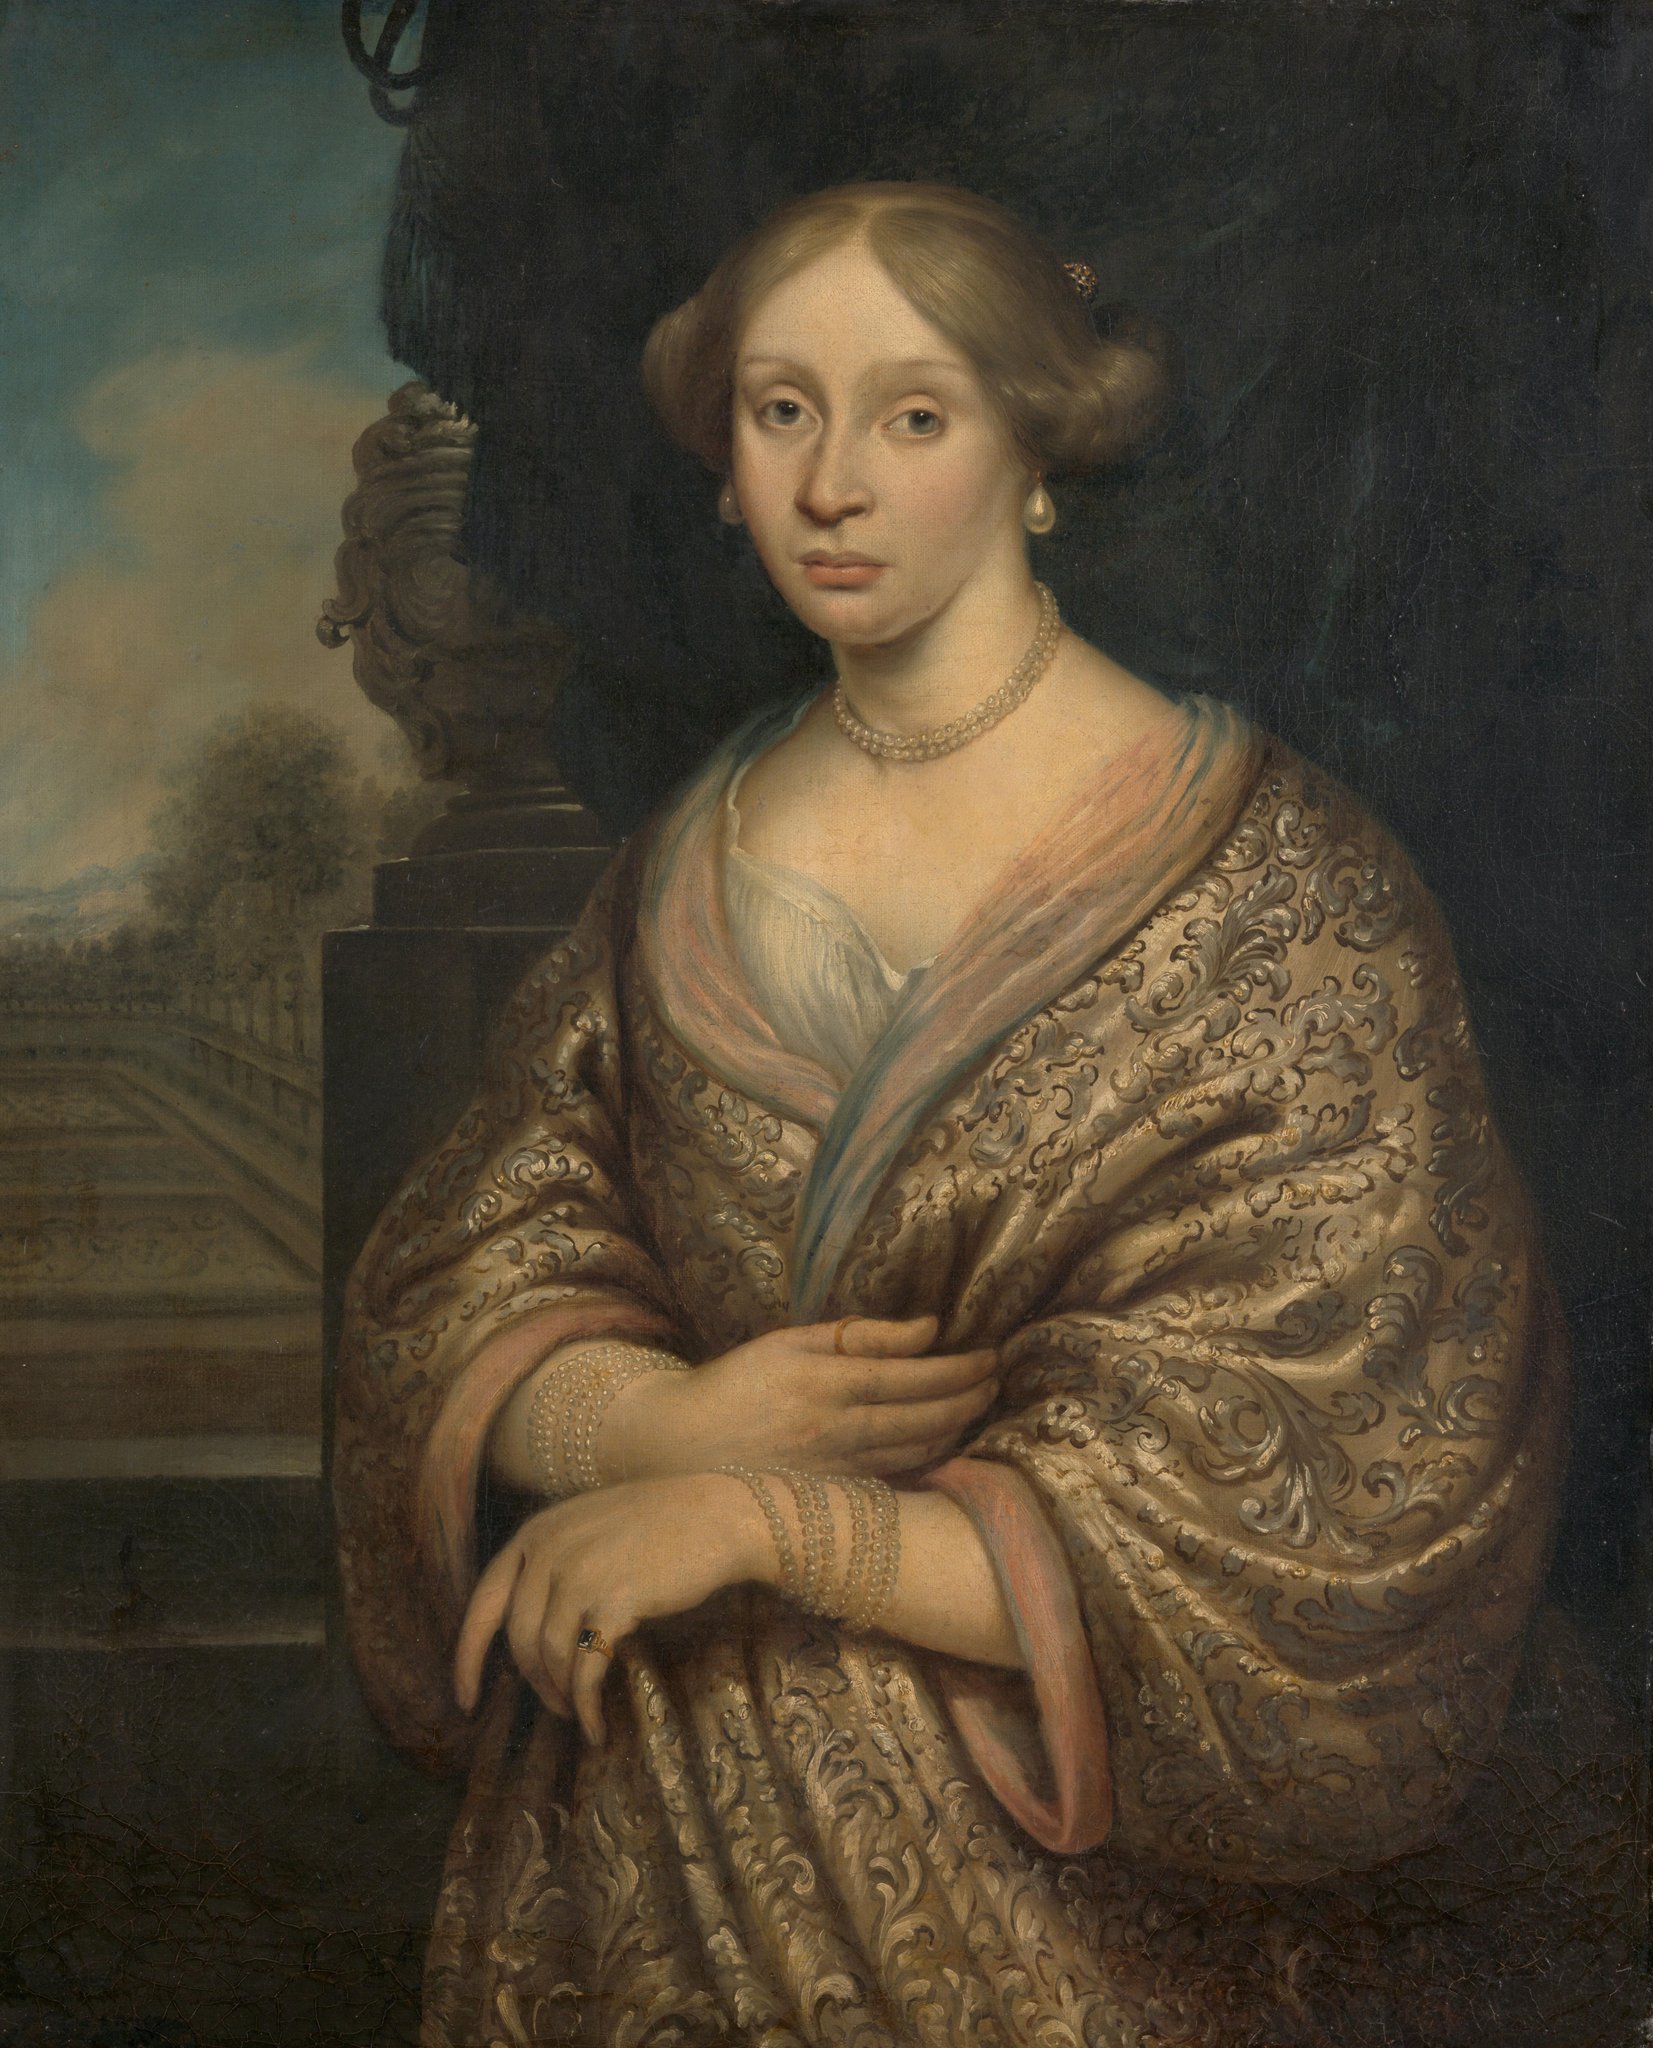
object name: painting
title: Portrait of Petronella van der Burcht (1657-1682)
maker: zacharias blijhooft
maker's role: draughtsman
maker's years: 1630-1682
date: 1674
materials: canvas, oil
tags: historical persons - bb - woman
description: Portret van Petronella van der Burcht, de eerste echtgenote van François Leidecker. Heupstuk, staande voor een urn op een voetstuk, op de achtergrond een formele tuin. Pendant van SK-A-825.